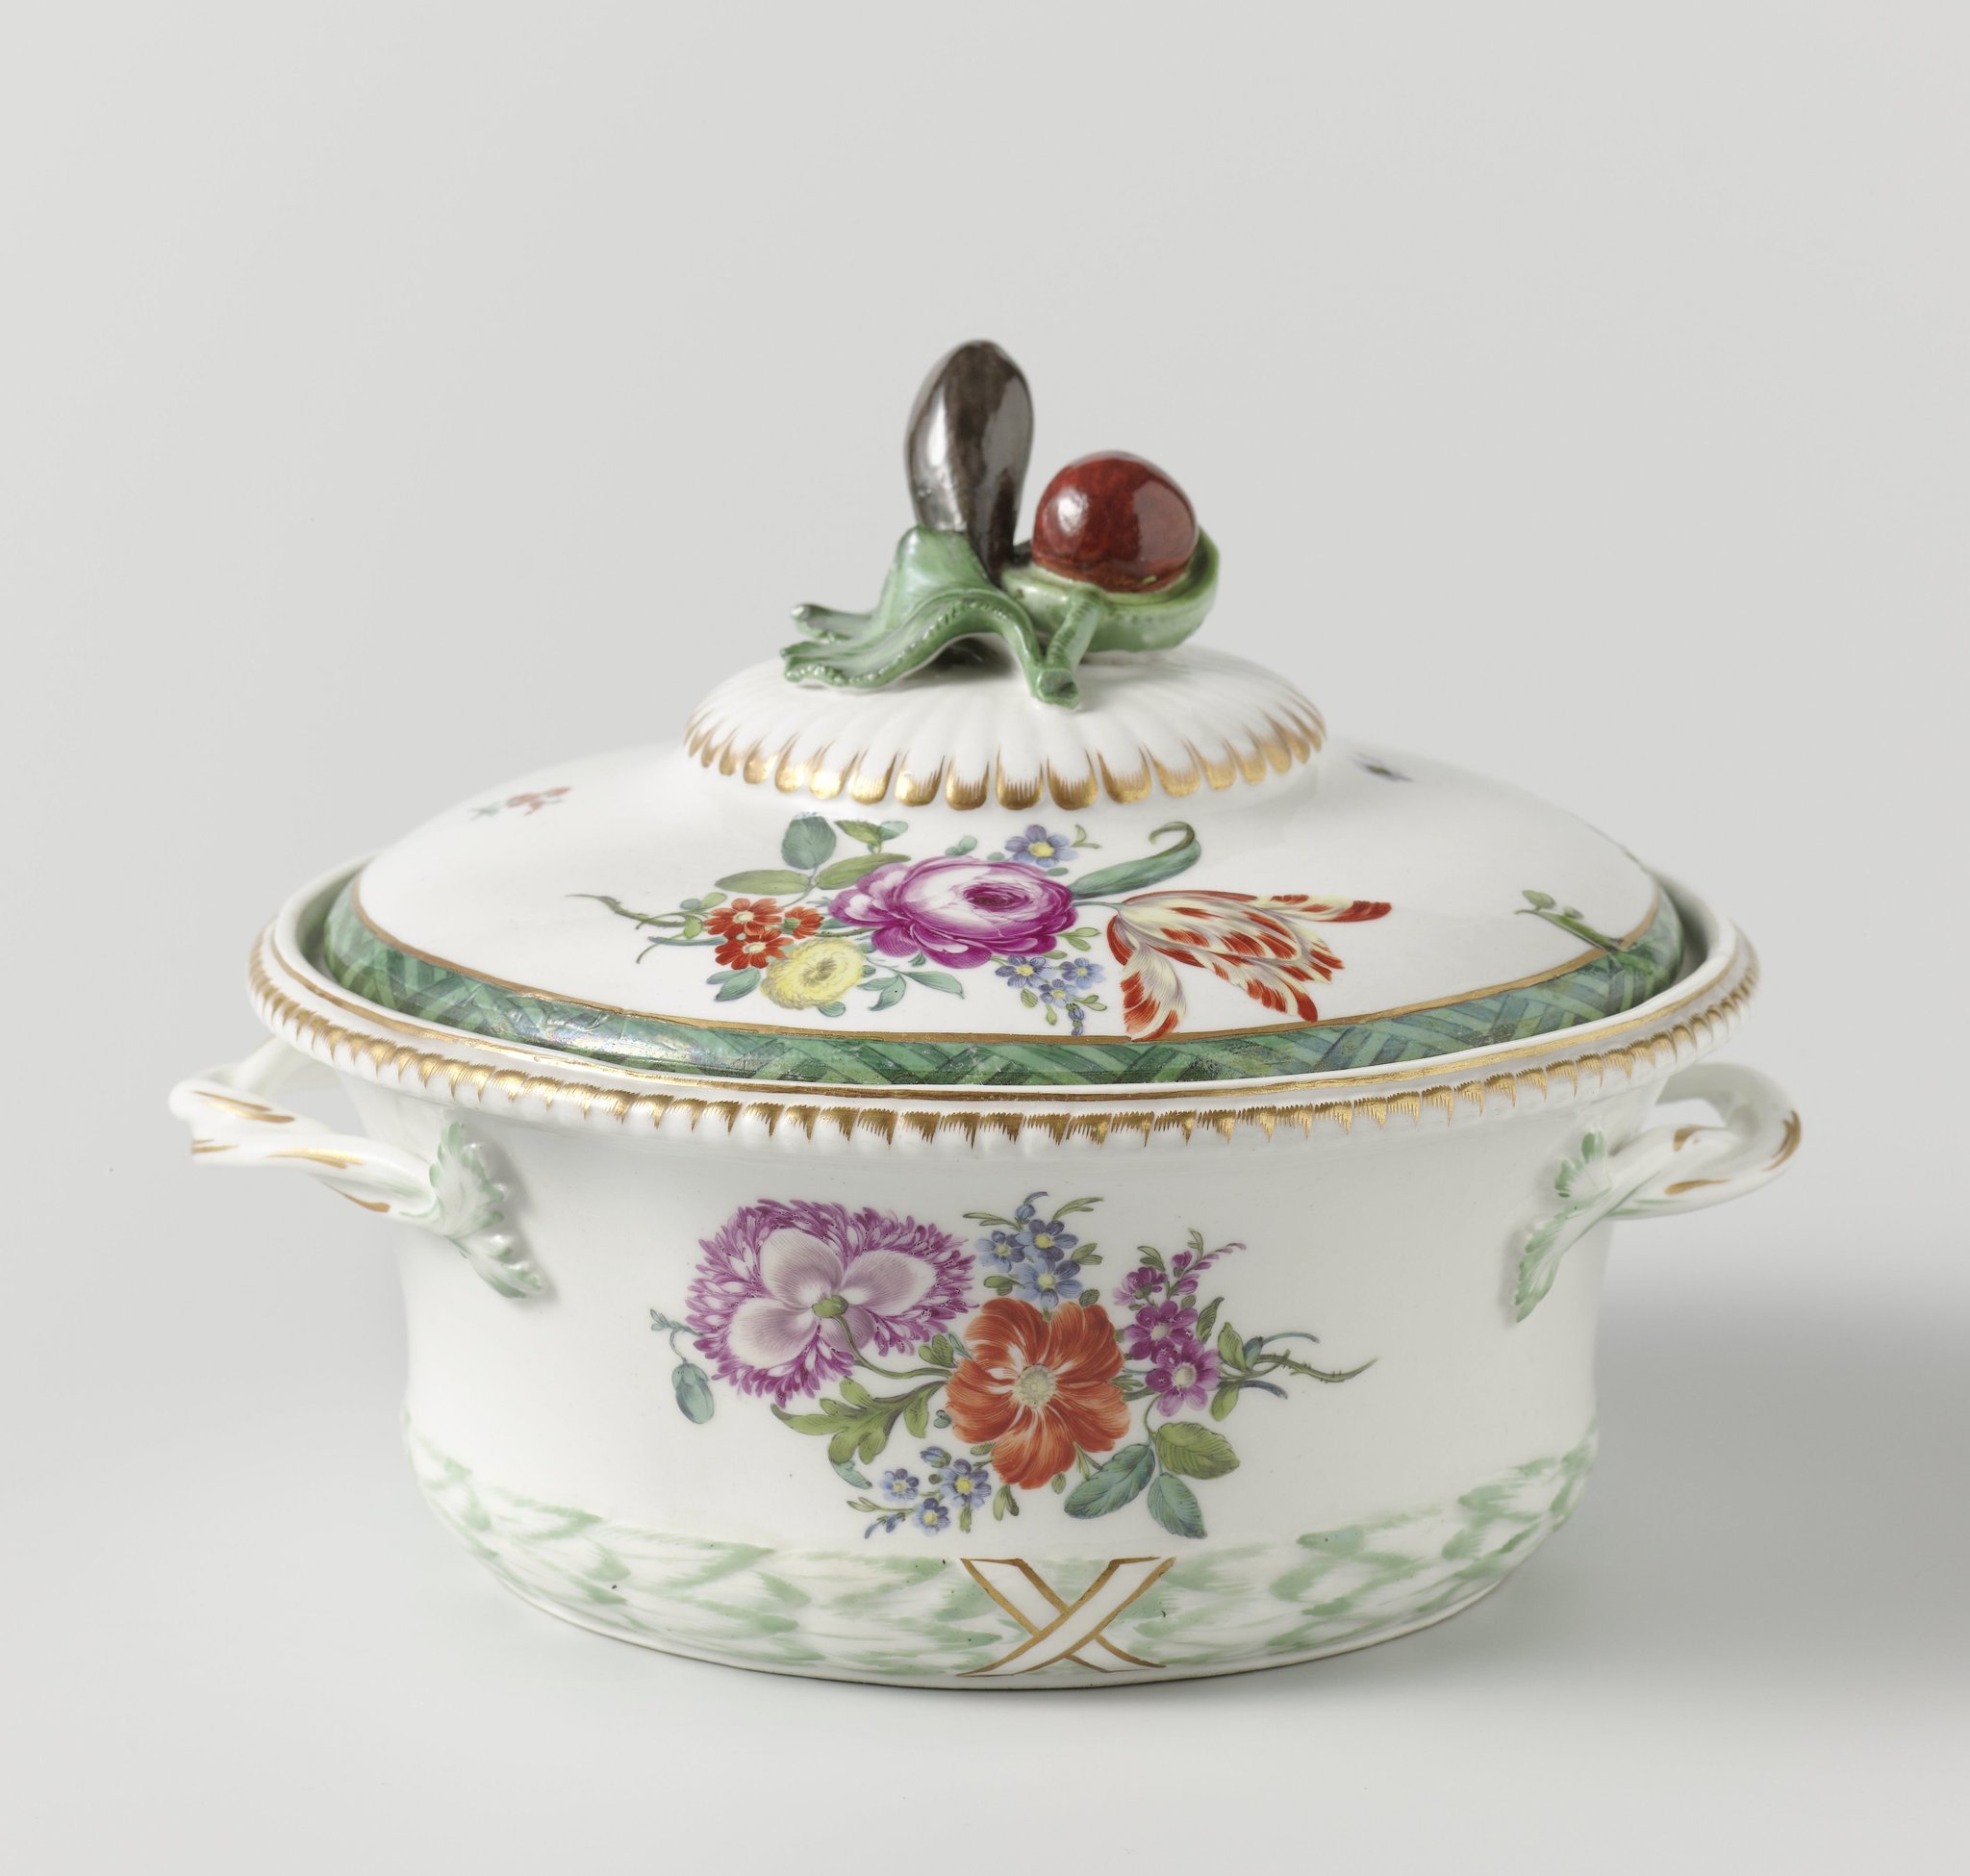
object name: tureen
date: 1778-1782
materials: porcelain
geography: loosdrecht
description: Manufactuur Oud-Loosdrecht Loosdrecht, c. 1778–1782 hard-paste porcelain